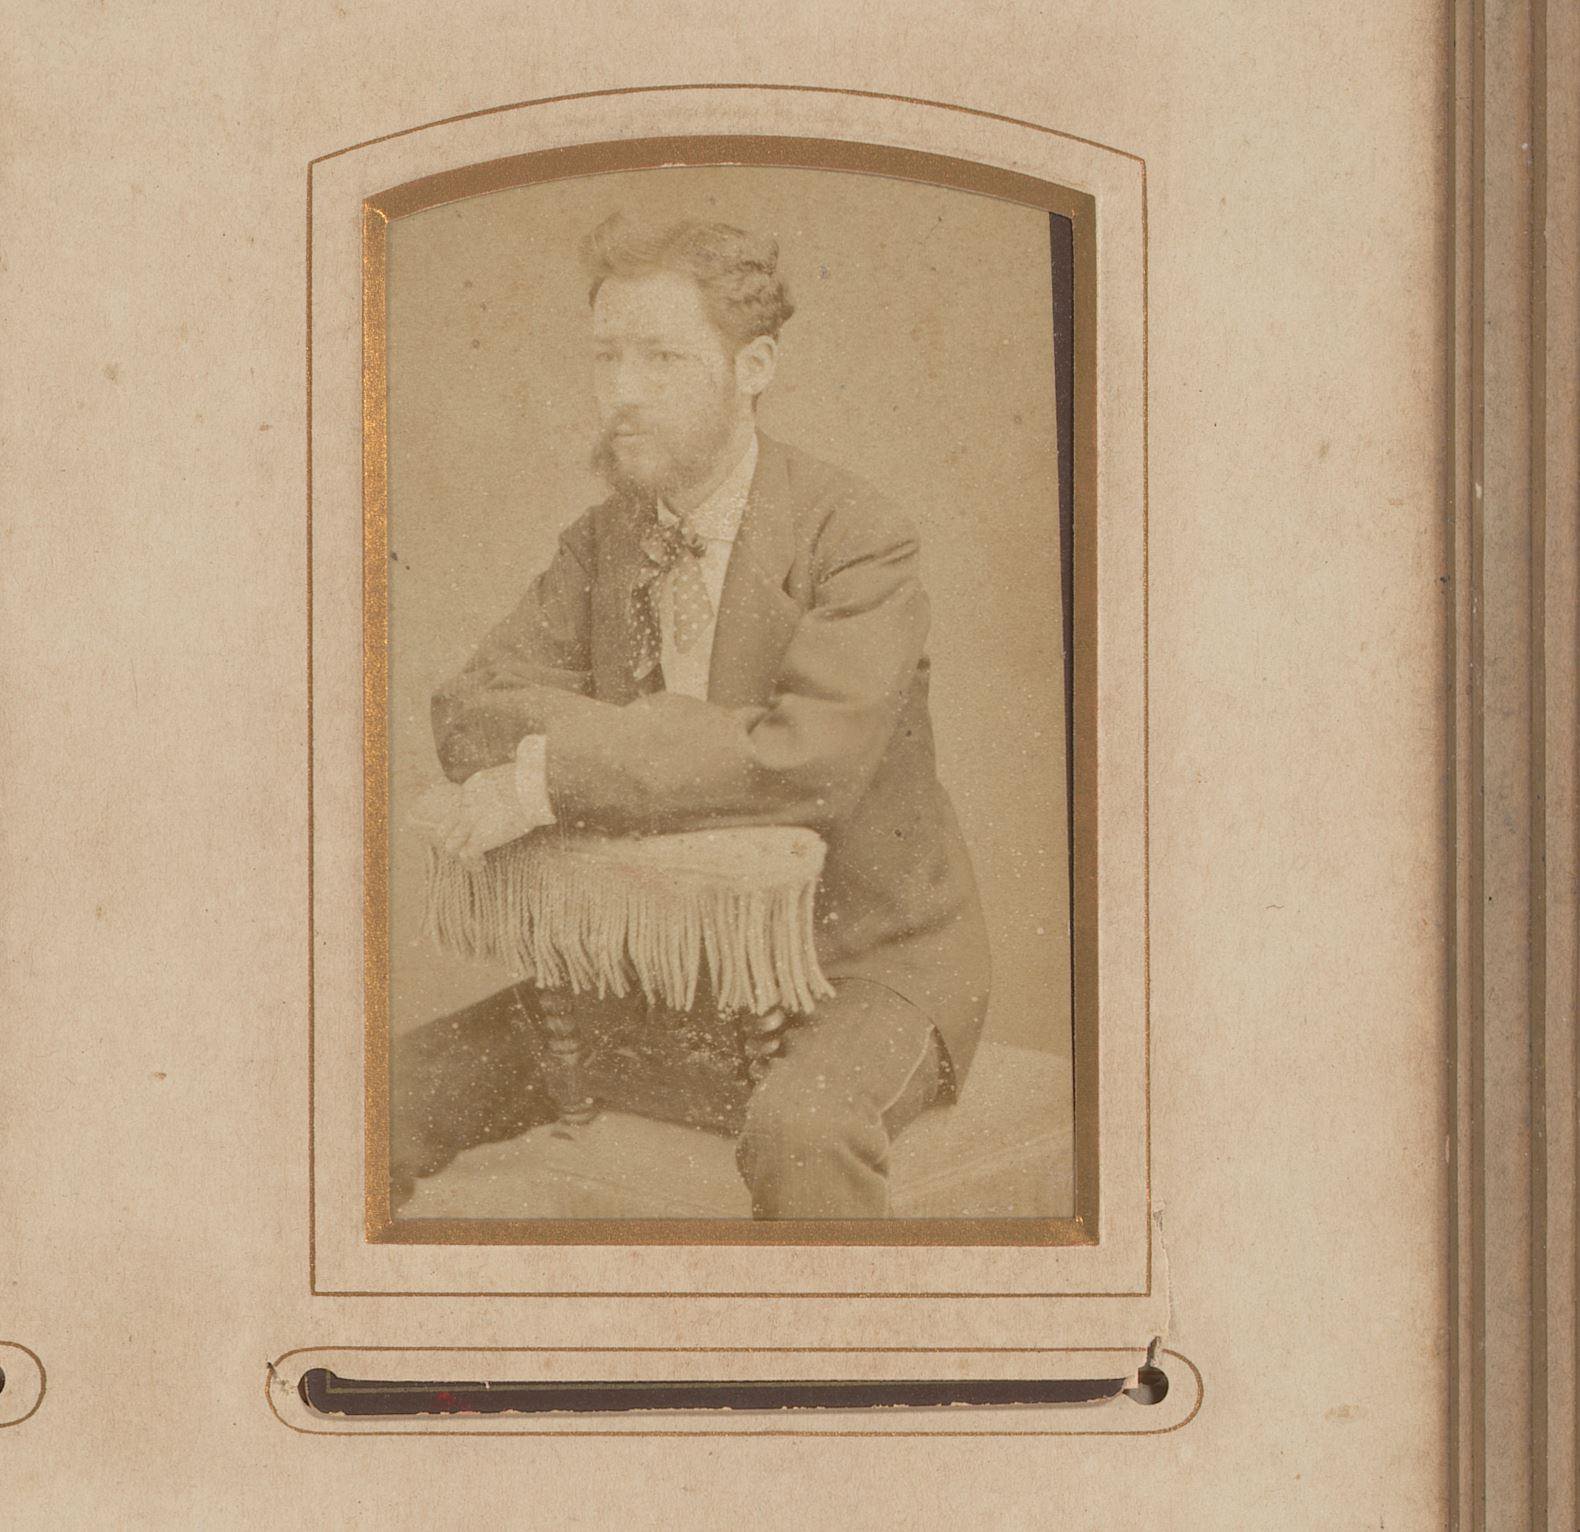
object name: album leaf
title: Portret van een zittende man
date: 1865-1903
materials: cardboard, photographic support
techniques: albumen print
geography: the hague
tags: sitting figure, historical persons, chair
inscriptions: inscription: ‘De lavieter & Co/ Photographes/ Willemstraat No. 2/ La Haye.’